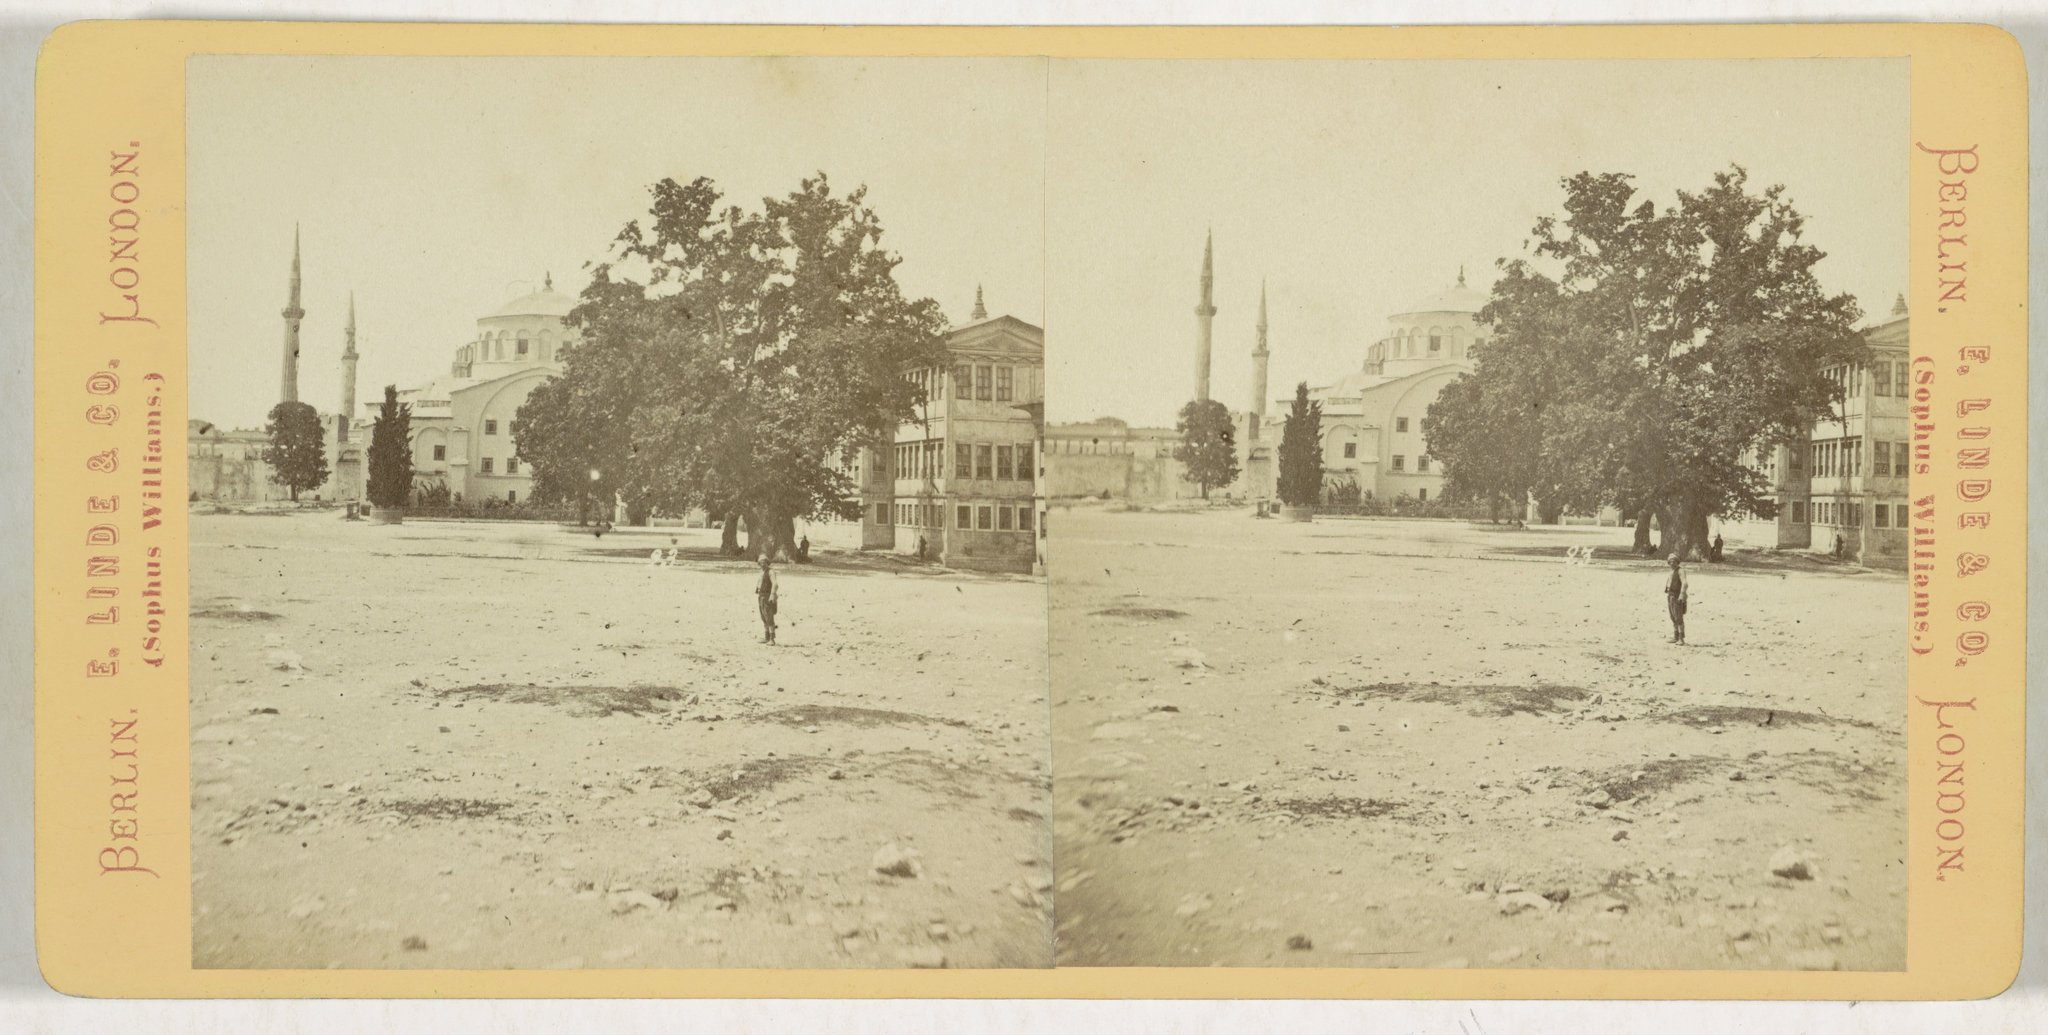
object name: stereograph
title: Gezicht op de Hagia Irene in Istanboel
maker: Anonymous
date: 1873-1890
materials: cardboard, paper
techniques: albumen print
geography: hagia irene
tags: temple, shrine ~ islam, mohammedanism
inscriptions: number: ‘23’